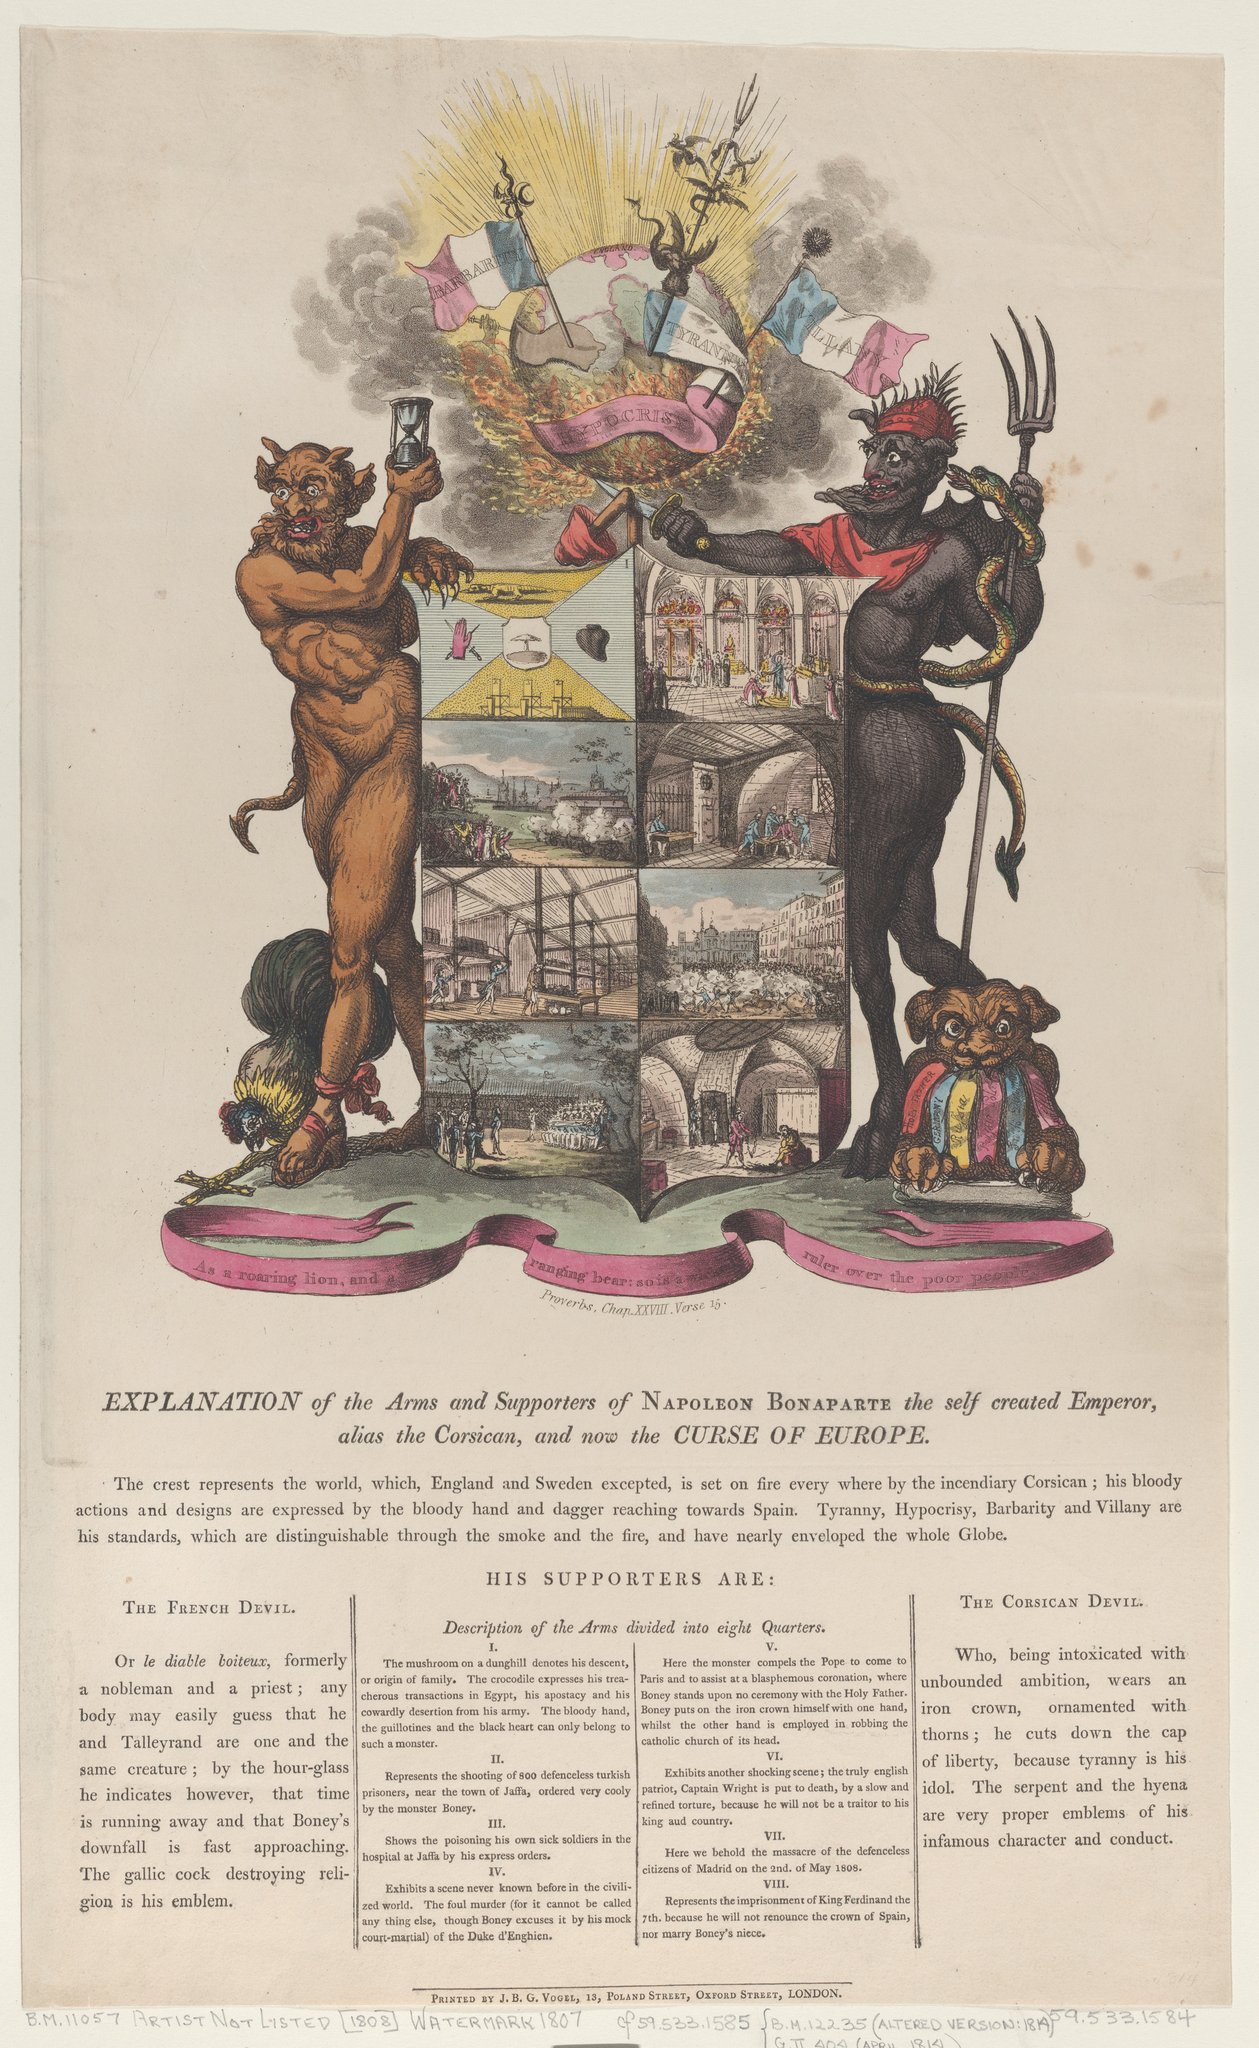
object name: print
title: Explanation of the Arms and Supporters of Napoleon Bonaparte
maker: anonymous, british, 19th century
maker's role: artist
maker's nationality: british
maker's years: 1800-1900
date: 1808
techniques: aquatint, etching, letterpress